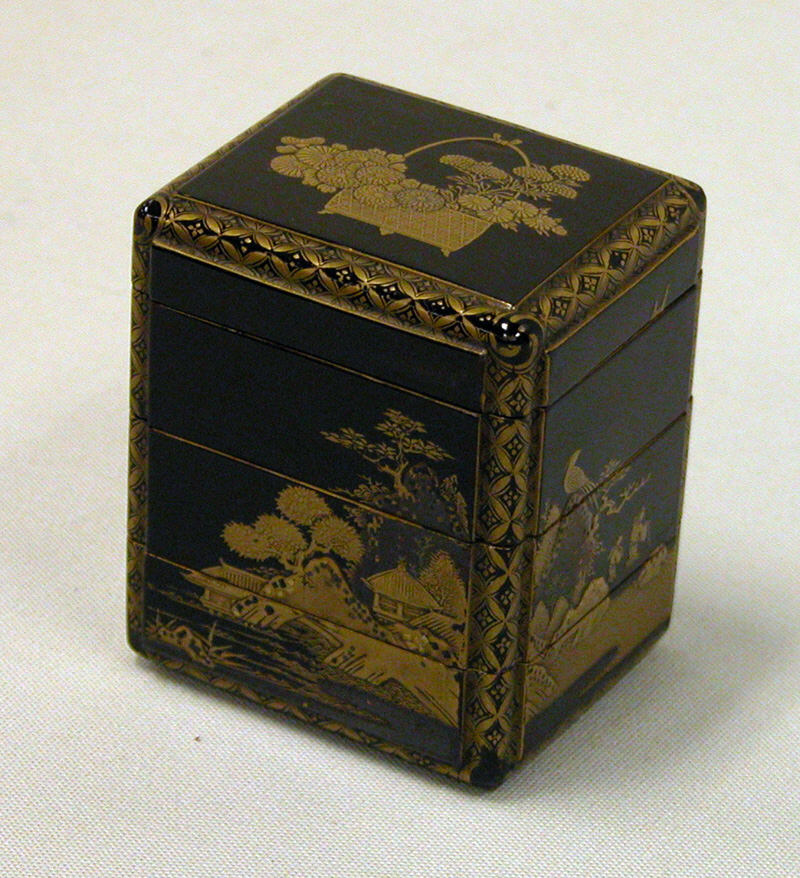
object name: incense box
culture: japanese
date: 1701-1733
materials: lacquer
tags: flowers